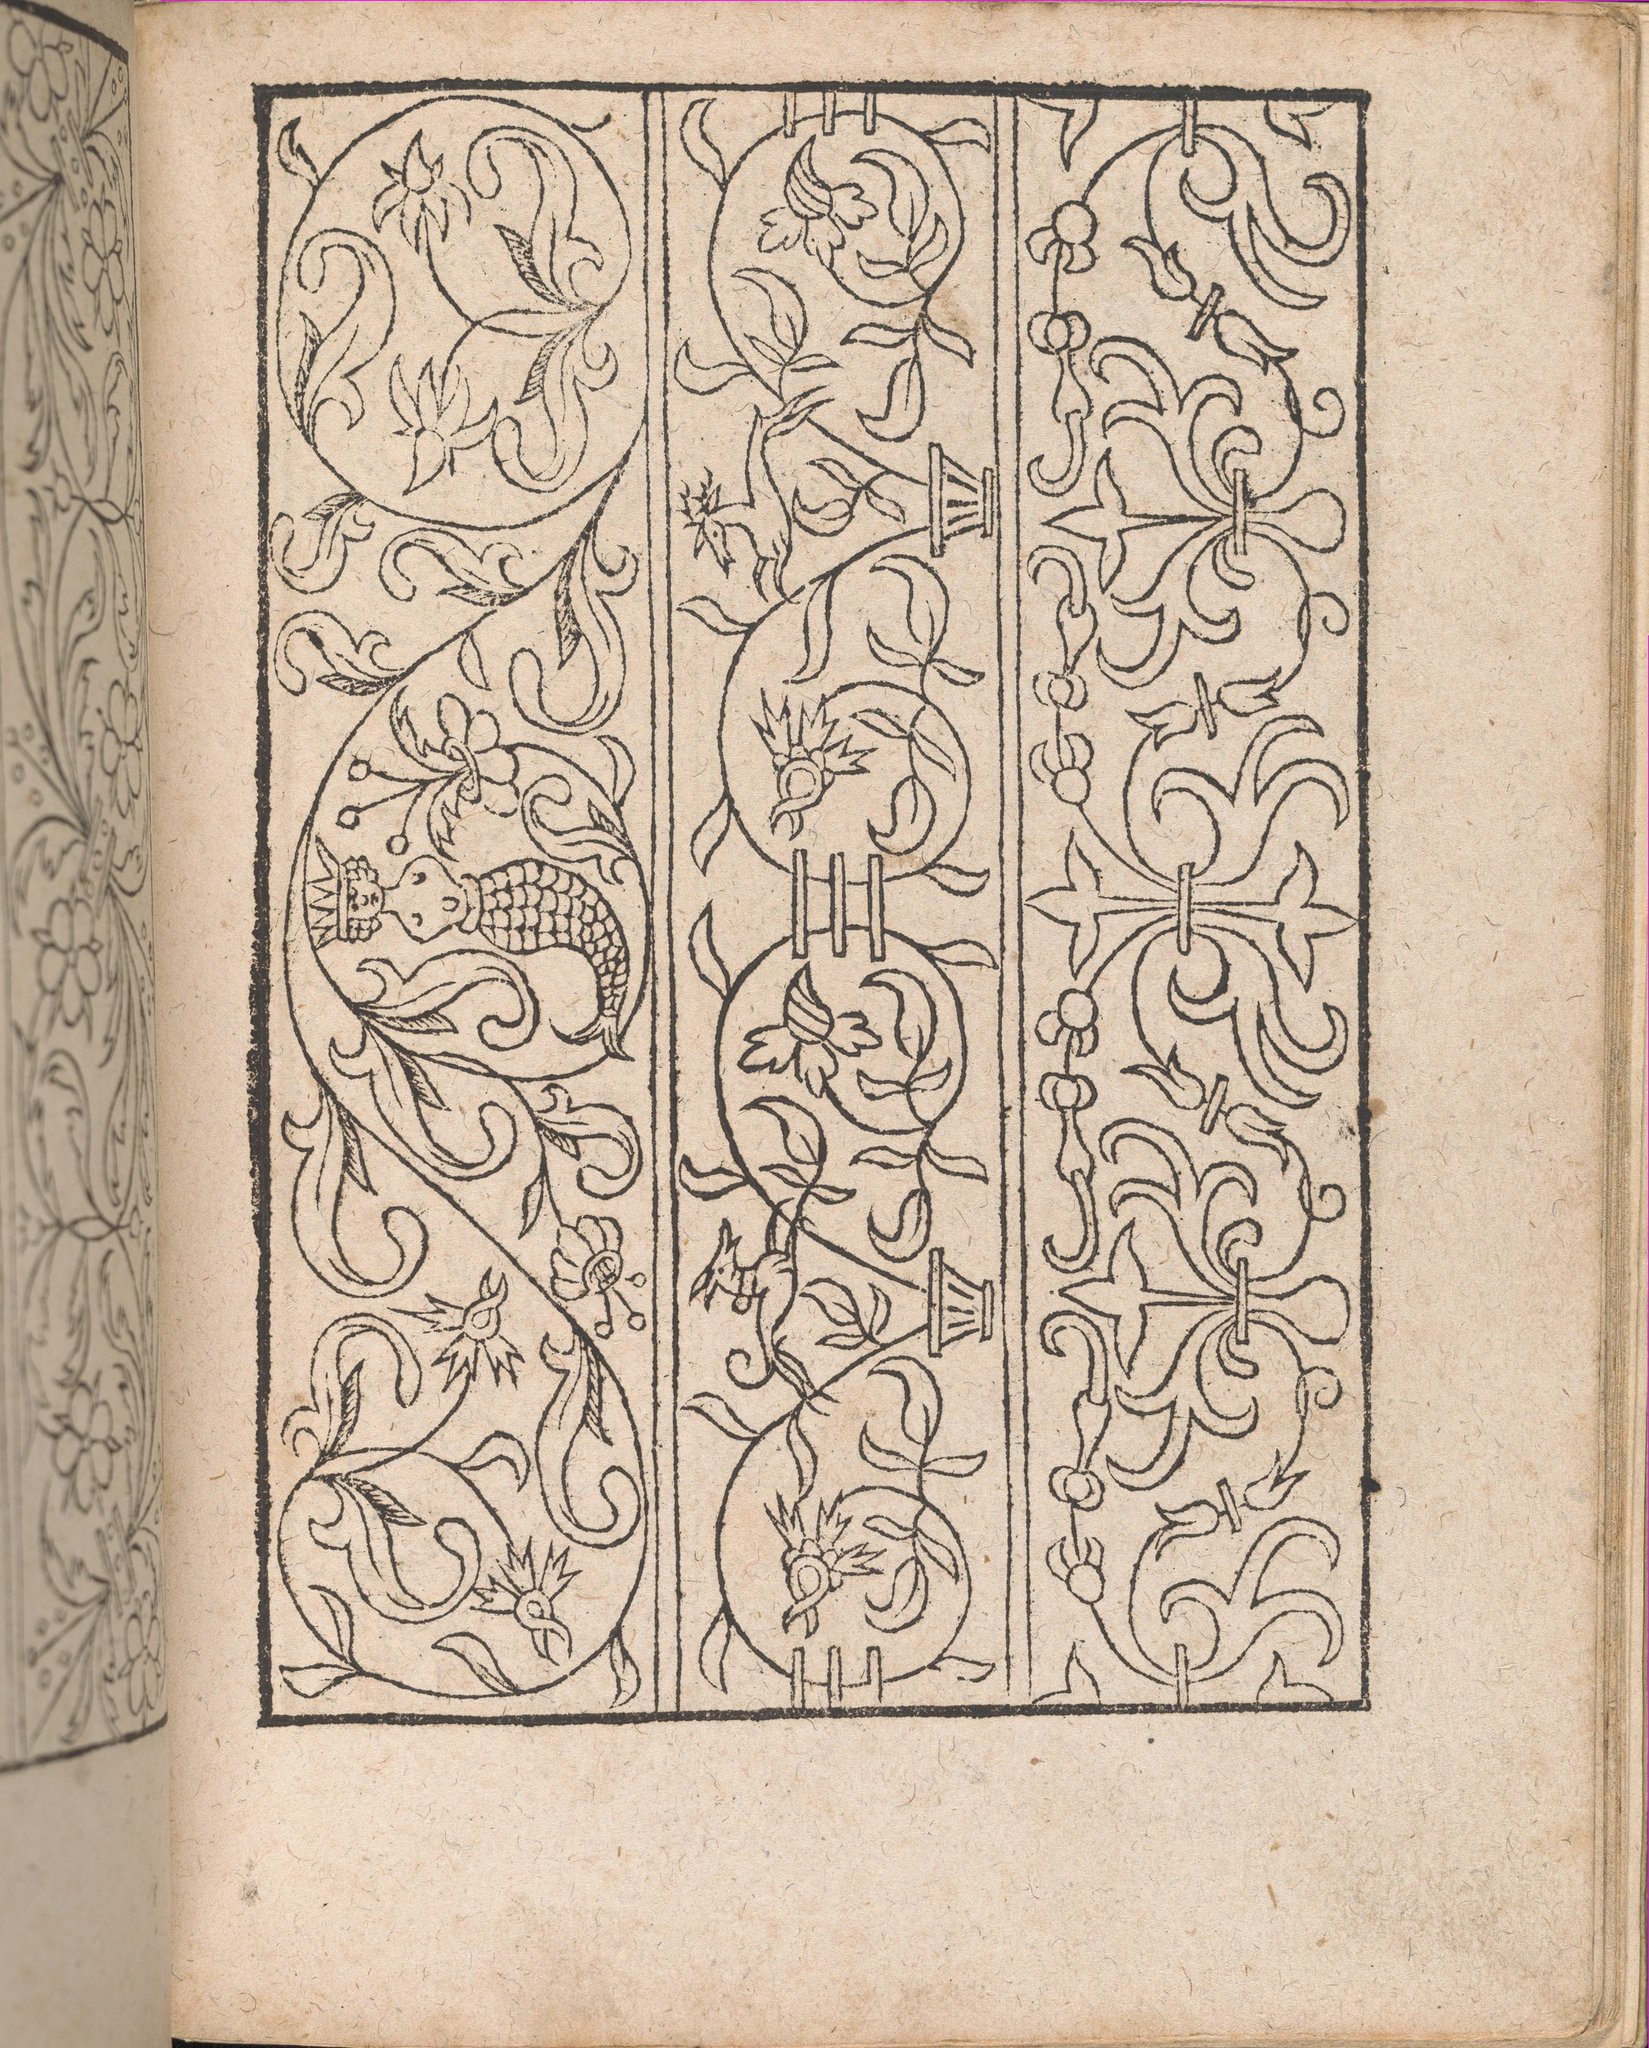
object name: book print ornament architecture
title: New Modelbüch allen Nägerin u. Sydenstickern (Page 20r)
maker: hans hoffman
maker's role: designer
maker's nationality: german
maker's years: 1556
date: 1556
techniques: woodcut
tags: flowers